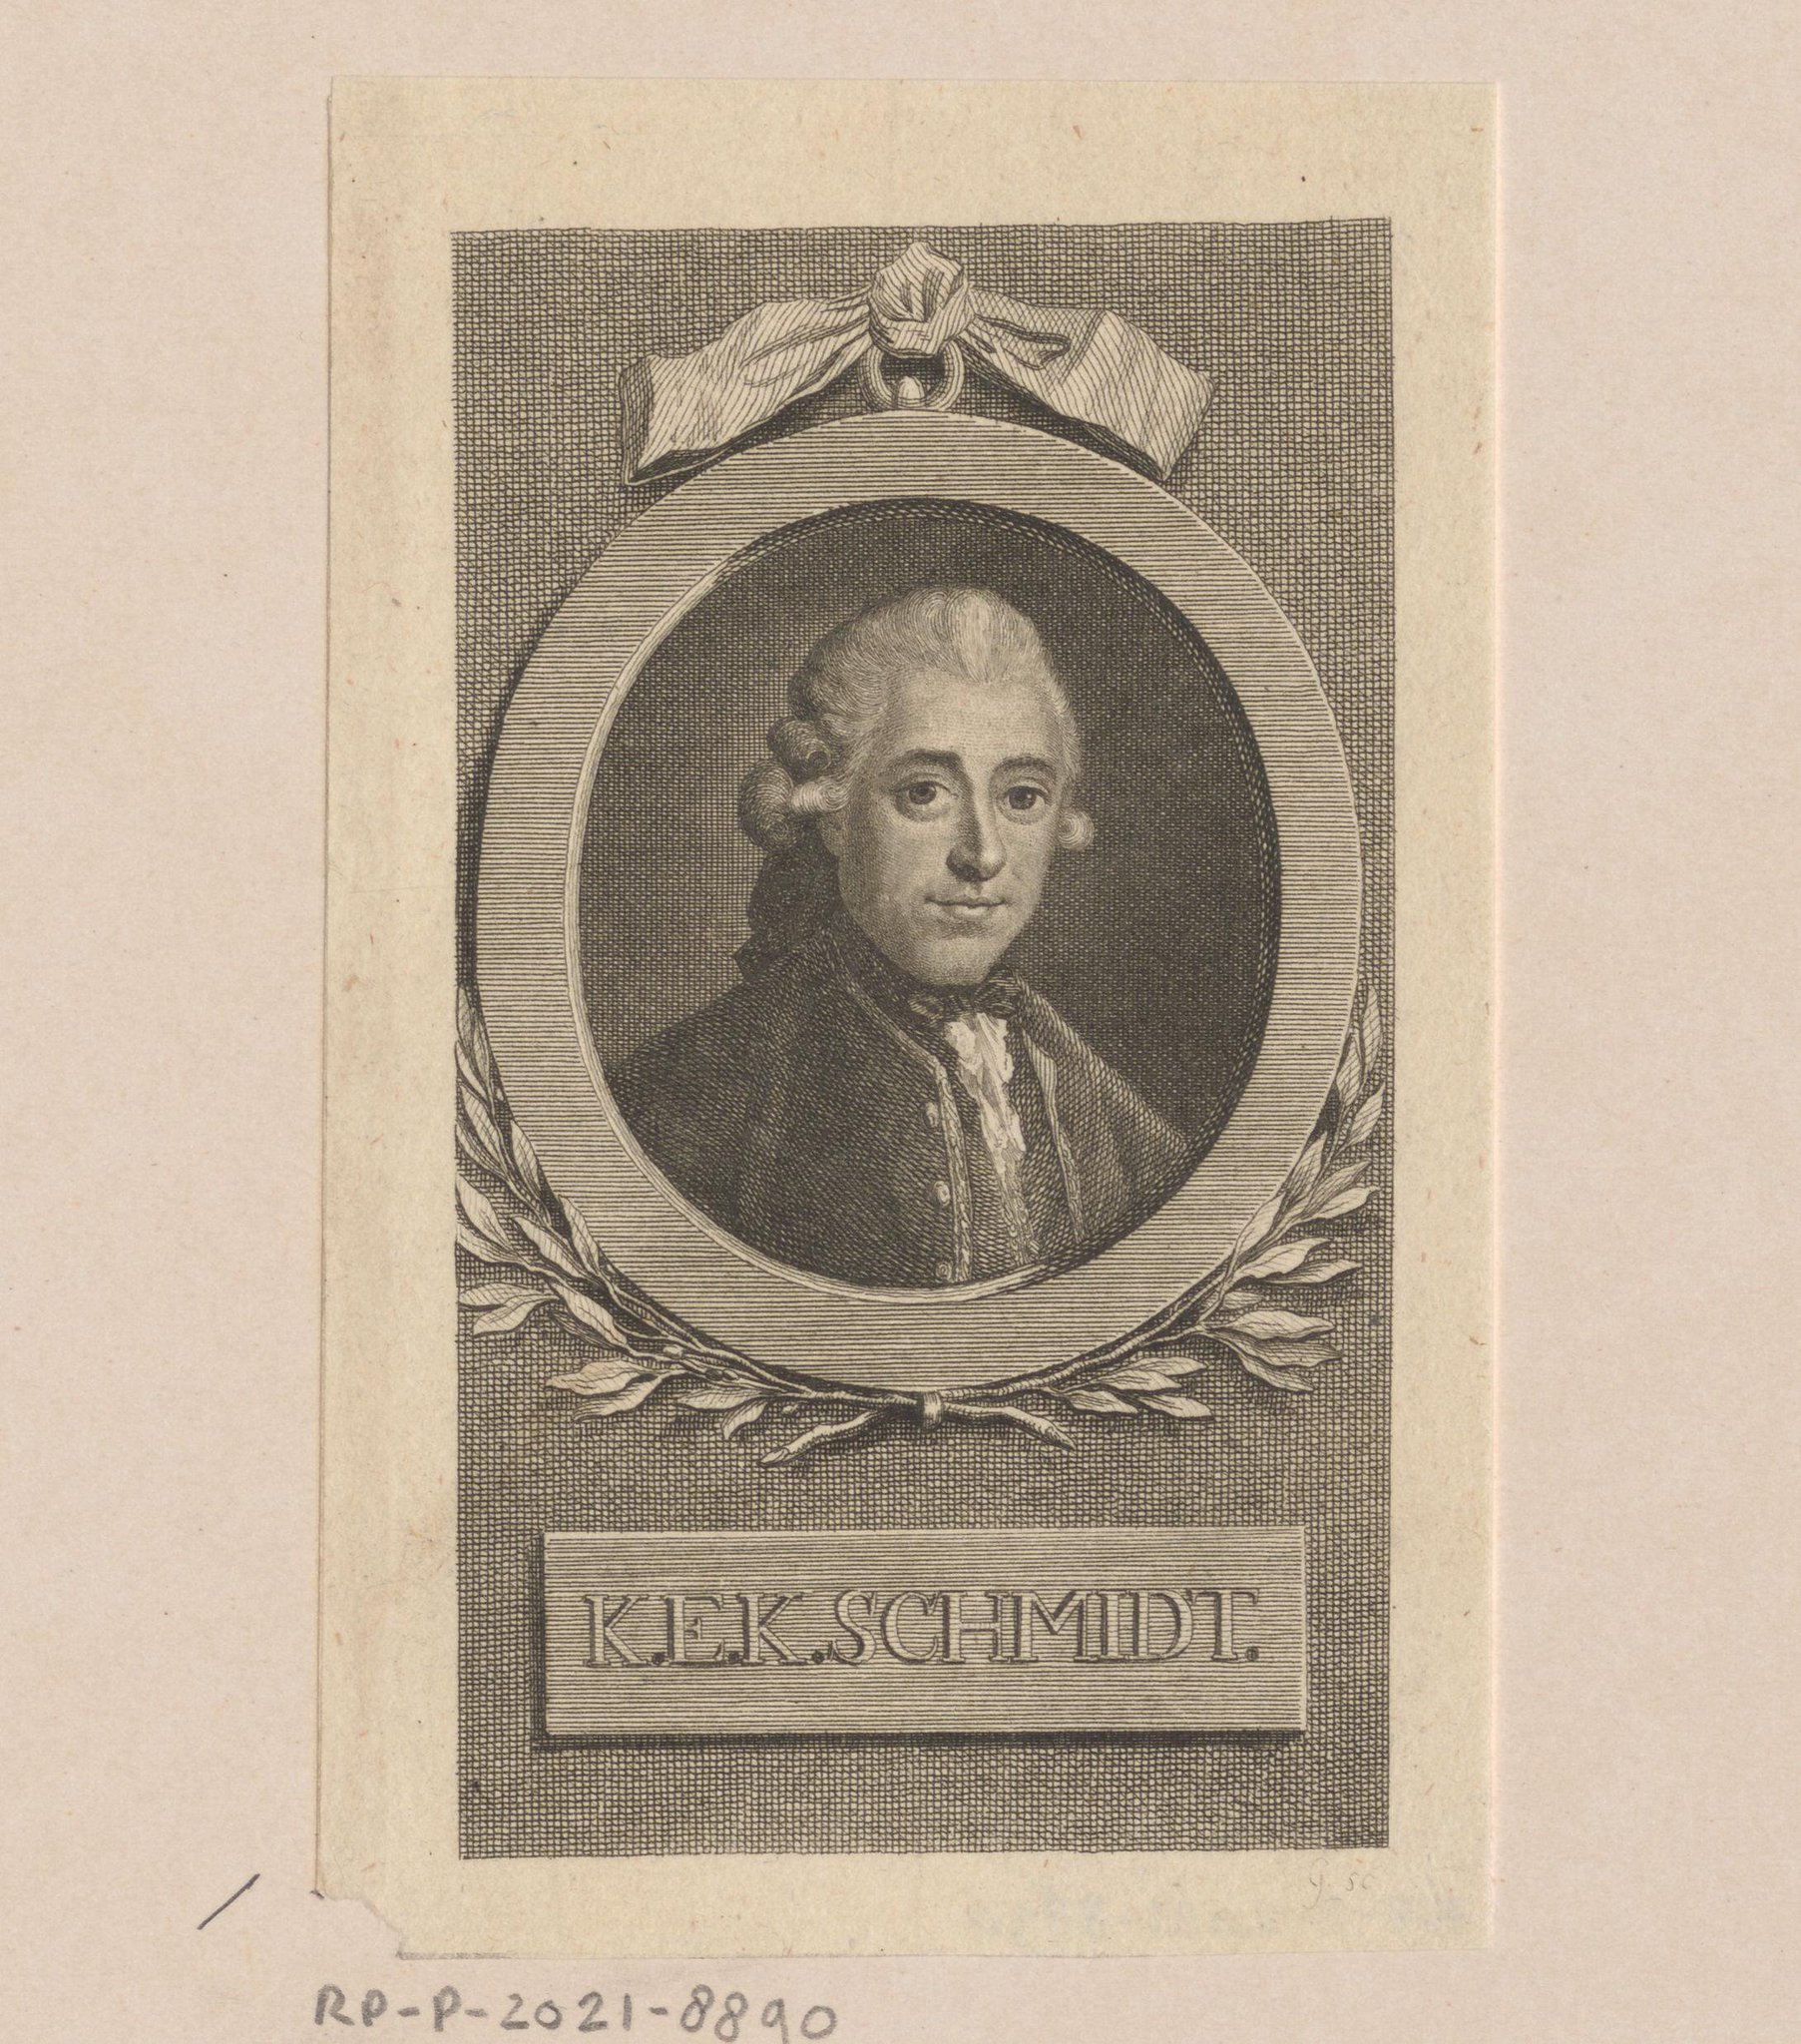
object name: print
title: Portret van Klamer Eberhard Karl Schmidt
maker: christian gottlieb geyser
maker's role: print maker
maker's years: 1742-1803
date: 1803-1867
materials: paper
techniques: etching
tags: historical persons, writer, poet, author